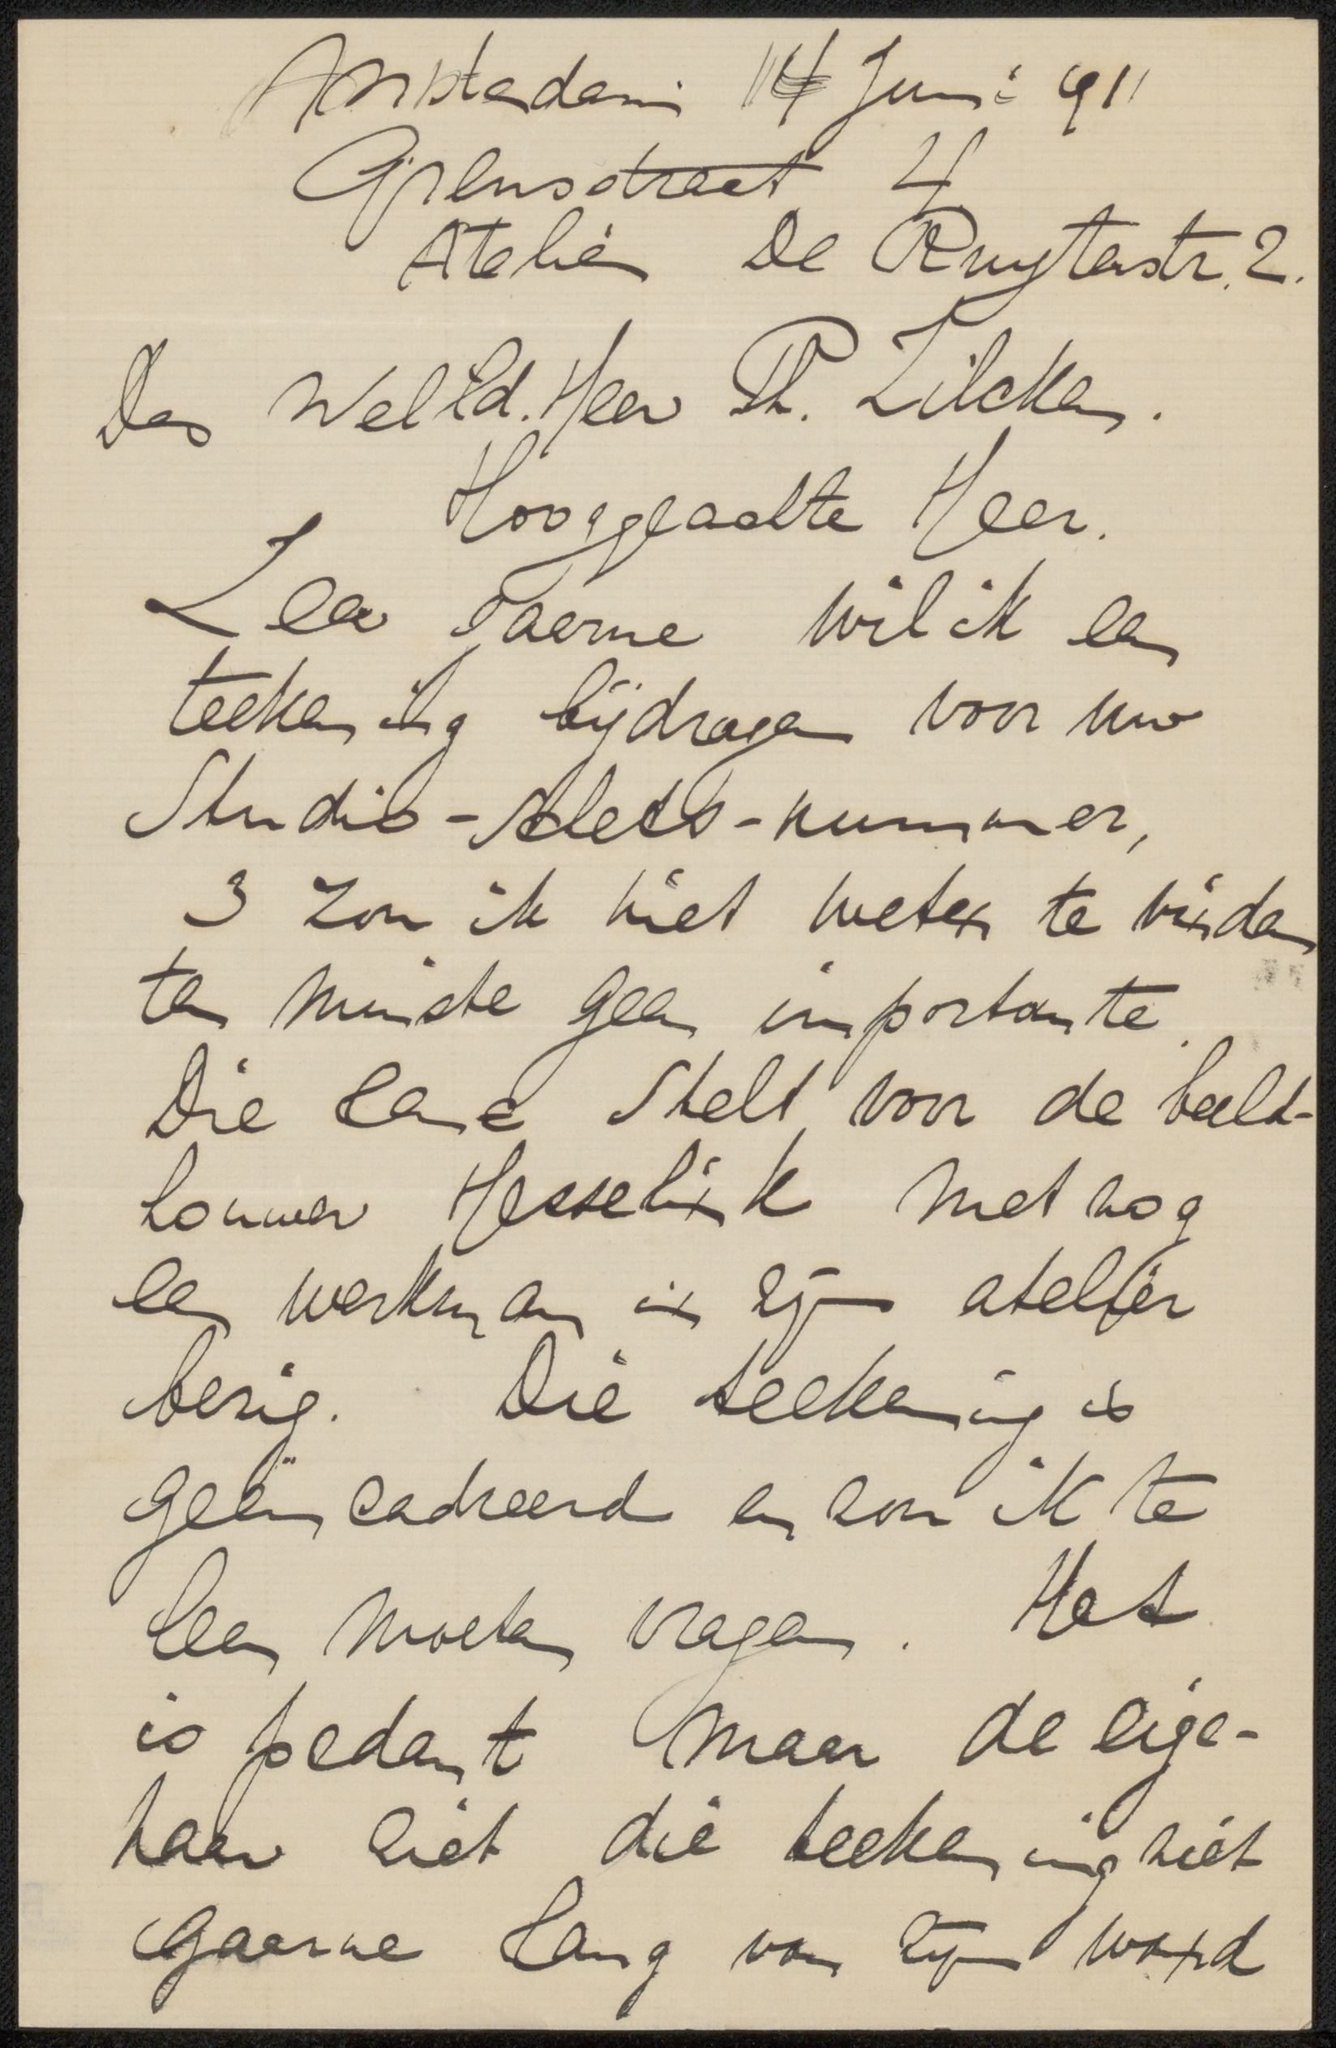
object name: letter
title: Brief aan Philip Zilcken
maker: martin monnickendam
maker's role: draughtsman, painter, print maker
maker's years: 1874-1943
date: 1911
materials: ink, paper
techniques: pen, writing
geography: amsterdam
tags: amsterdam, draughtsman, sculptor, abraham hesselink, publisher, the hague, painter, philip zilcken, drawing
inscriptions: collector's mark: ‘RPK’